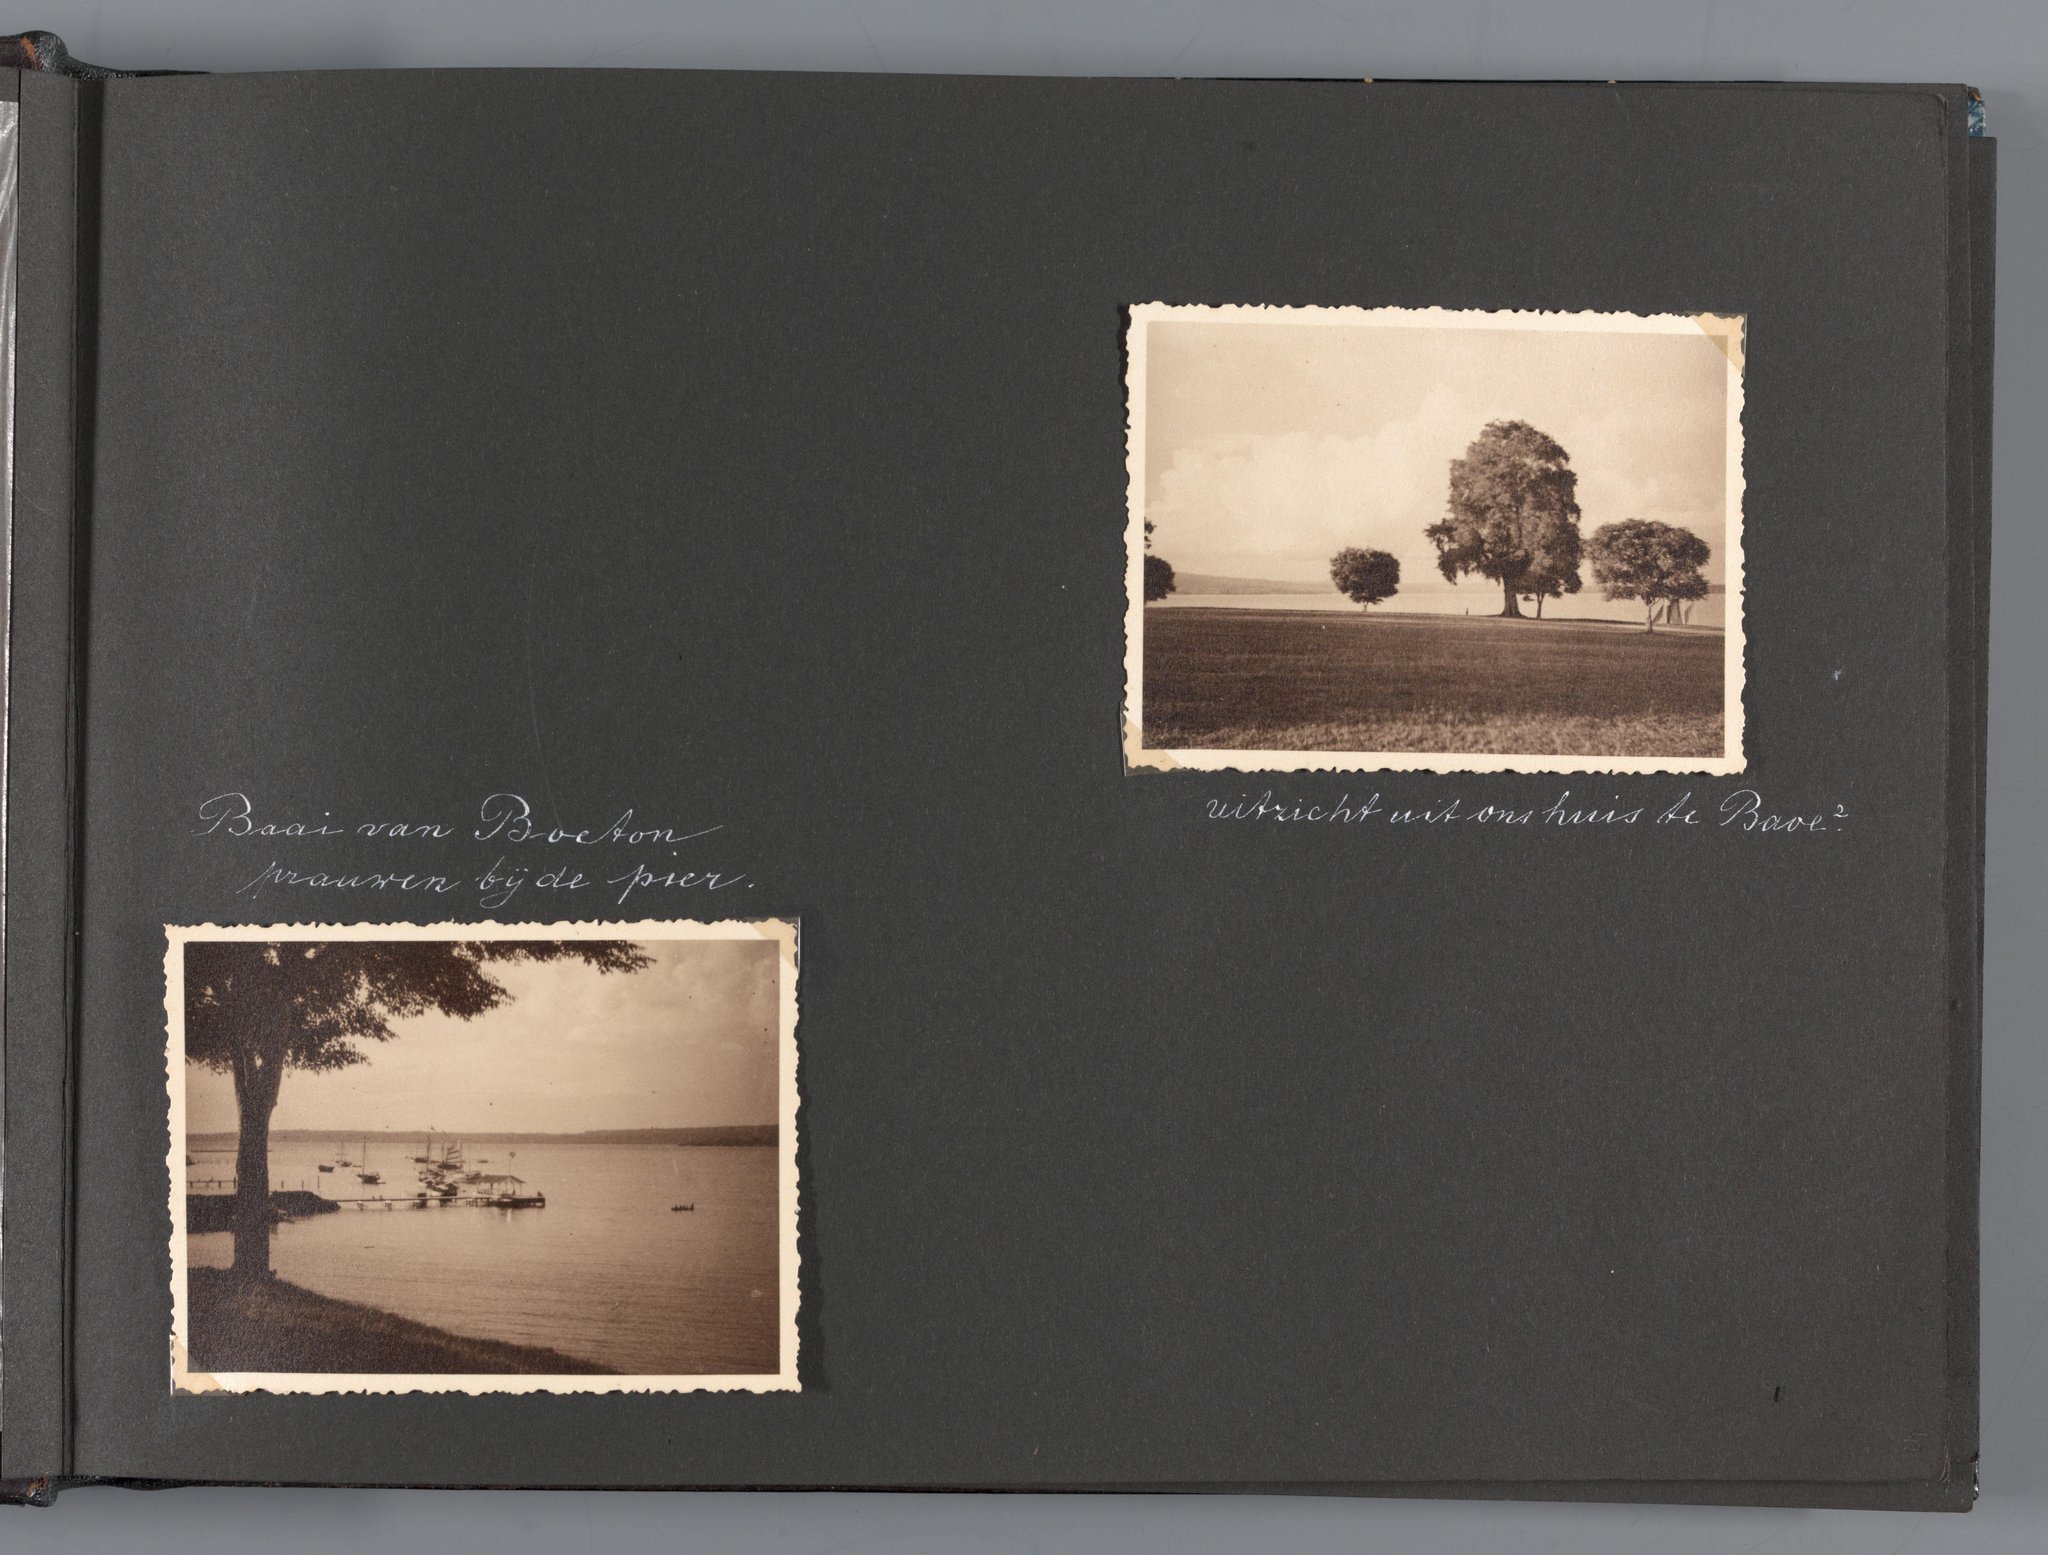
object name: album leaf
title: Landschappen op Celebes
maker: Anonymous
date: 1935-1938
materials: cardboard, photographic support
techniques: gelatin silver print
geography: celebes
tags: r.h. vonk, gulf, bay, coast (in tropical and sub-tropical regions)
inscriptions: inscription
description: Albumblad met twee foto's van de baai van Boeton en van het uitzicht vanuit het huis van de assistent-resident Vonk te Baoe, op Celebes. Onderdeel van het familiealbum van Jet Vonk uit Celebes.